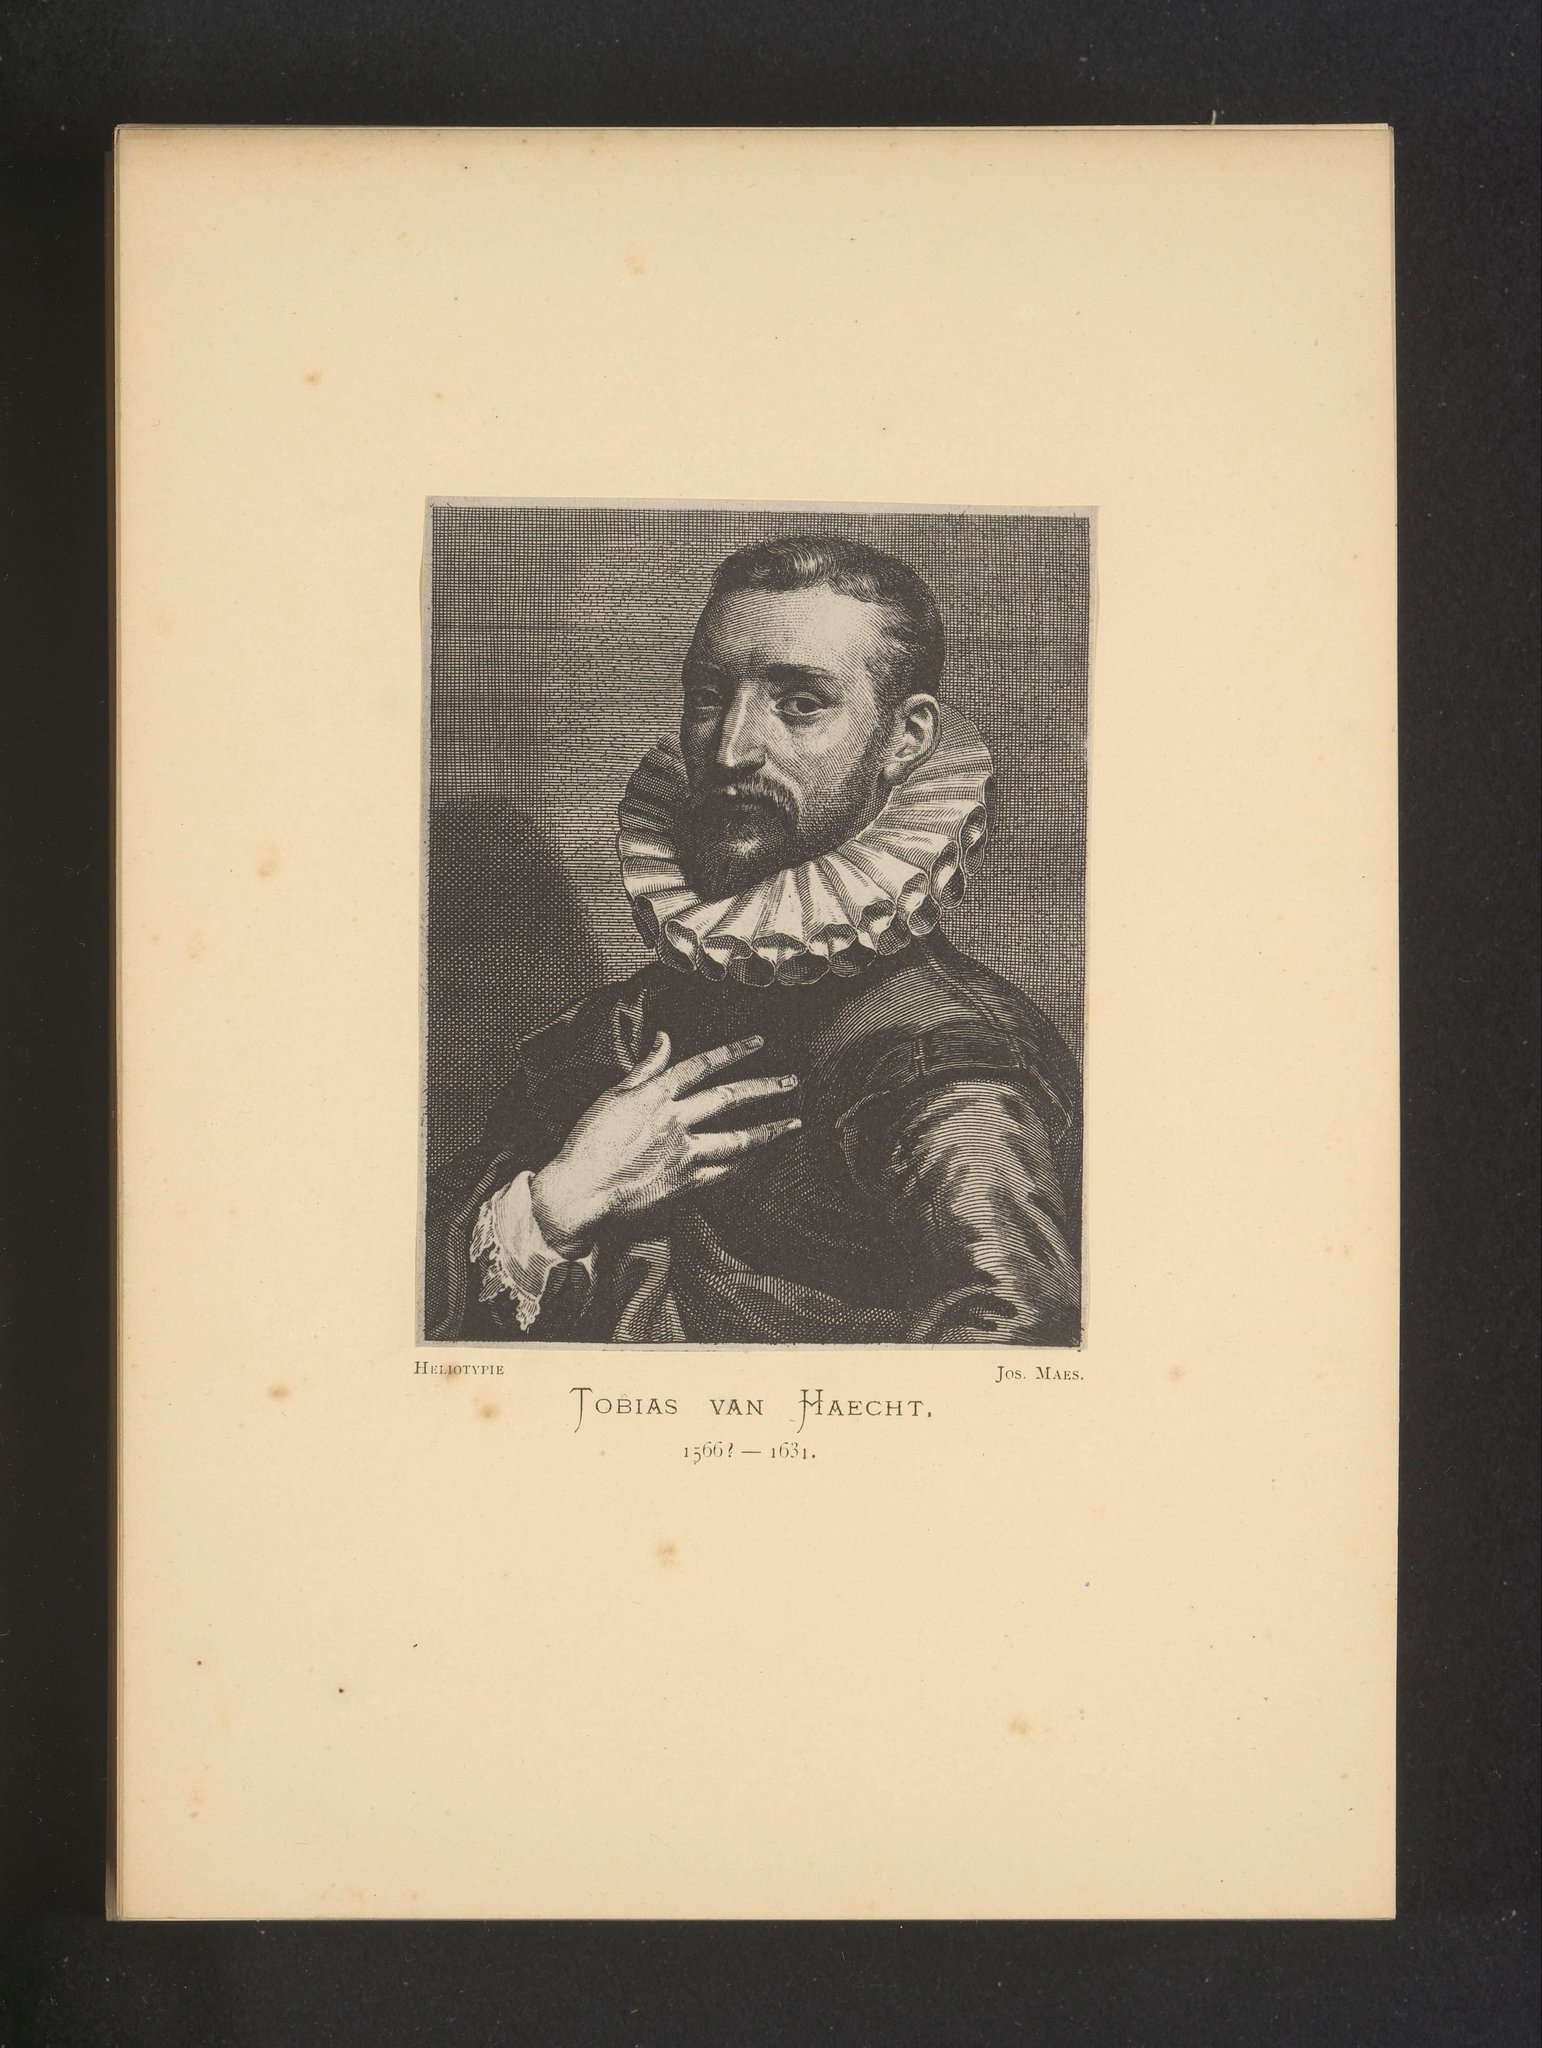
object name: photomechanical print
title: Reproductie van een gravure van een portret van Tobias Verhaecht door Cornelis van Caukercken en Otto van Veen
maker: joseph maes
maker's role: fotograaf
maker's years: 1838-1908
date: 1872-1877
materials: cardboard, paper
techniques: photograph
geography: antwerp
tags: antwerp, draughtsman, tobias verhaecht, historical persons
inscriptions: inscription: ‘1566? - 1631.’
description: Deze prent maakt deel uit van een omslag met 150 prenten en een katern met een lijst van afbeeldingen.